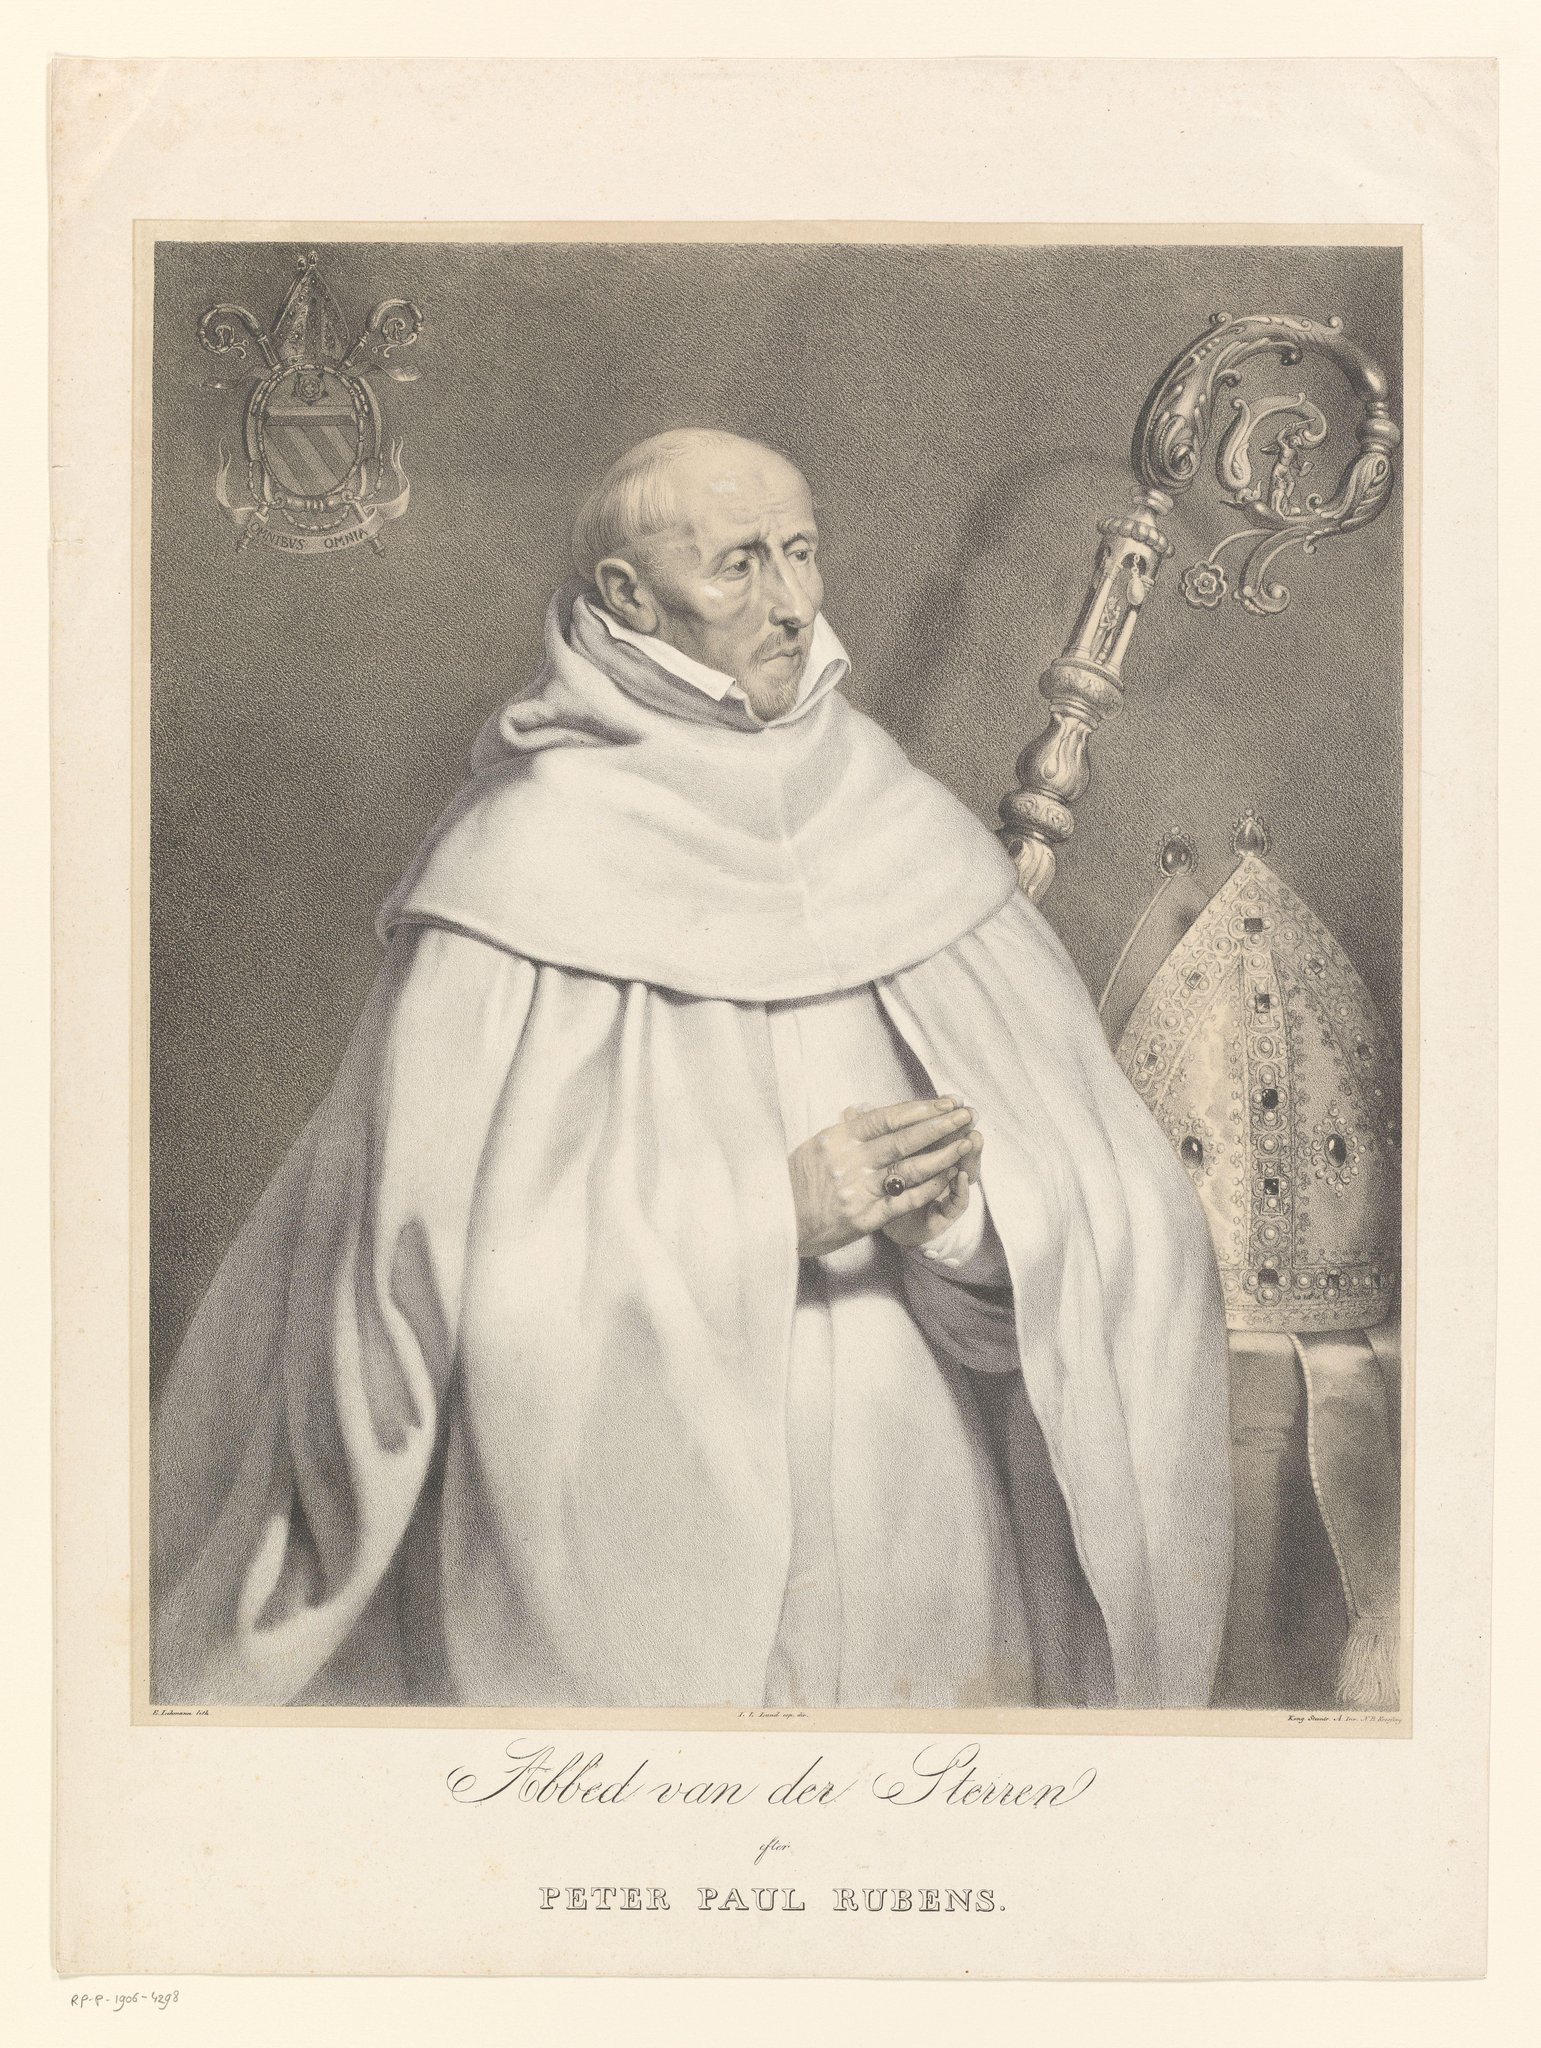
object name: print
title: Abbed van der Sterren after Peter Paul Rubens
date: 1825-1892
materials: paper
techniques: tone lithography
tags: abbot, adult man, historical persons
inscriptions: collector's mark: Lugt 2228